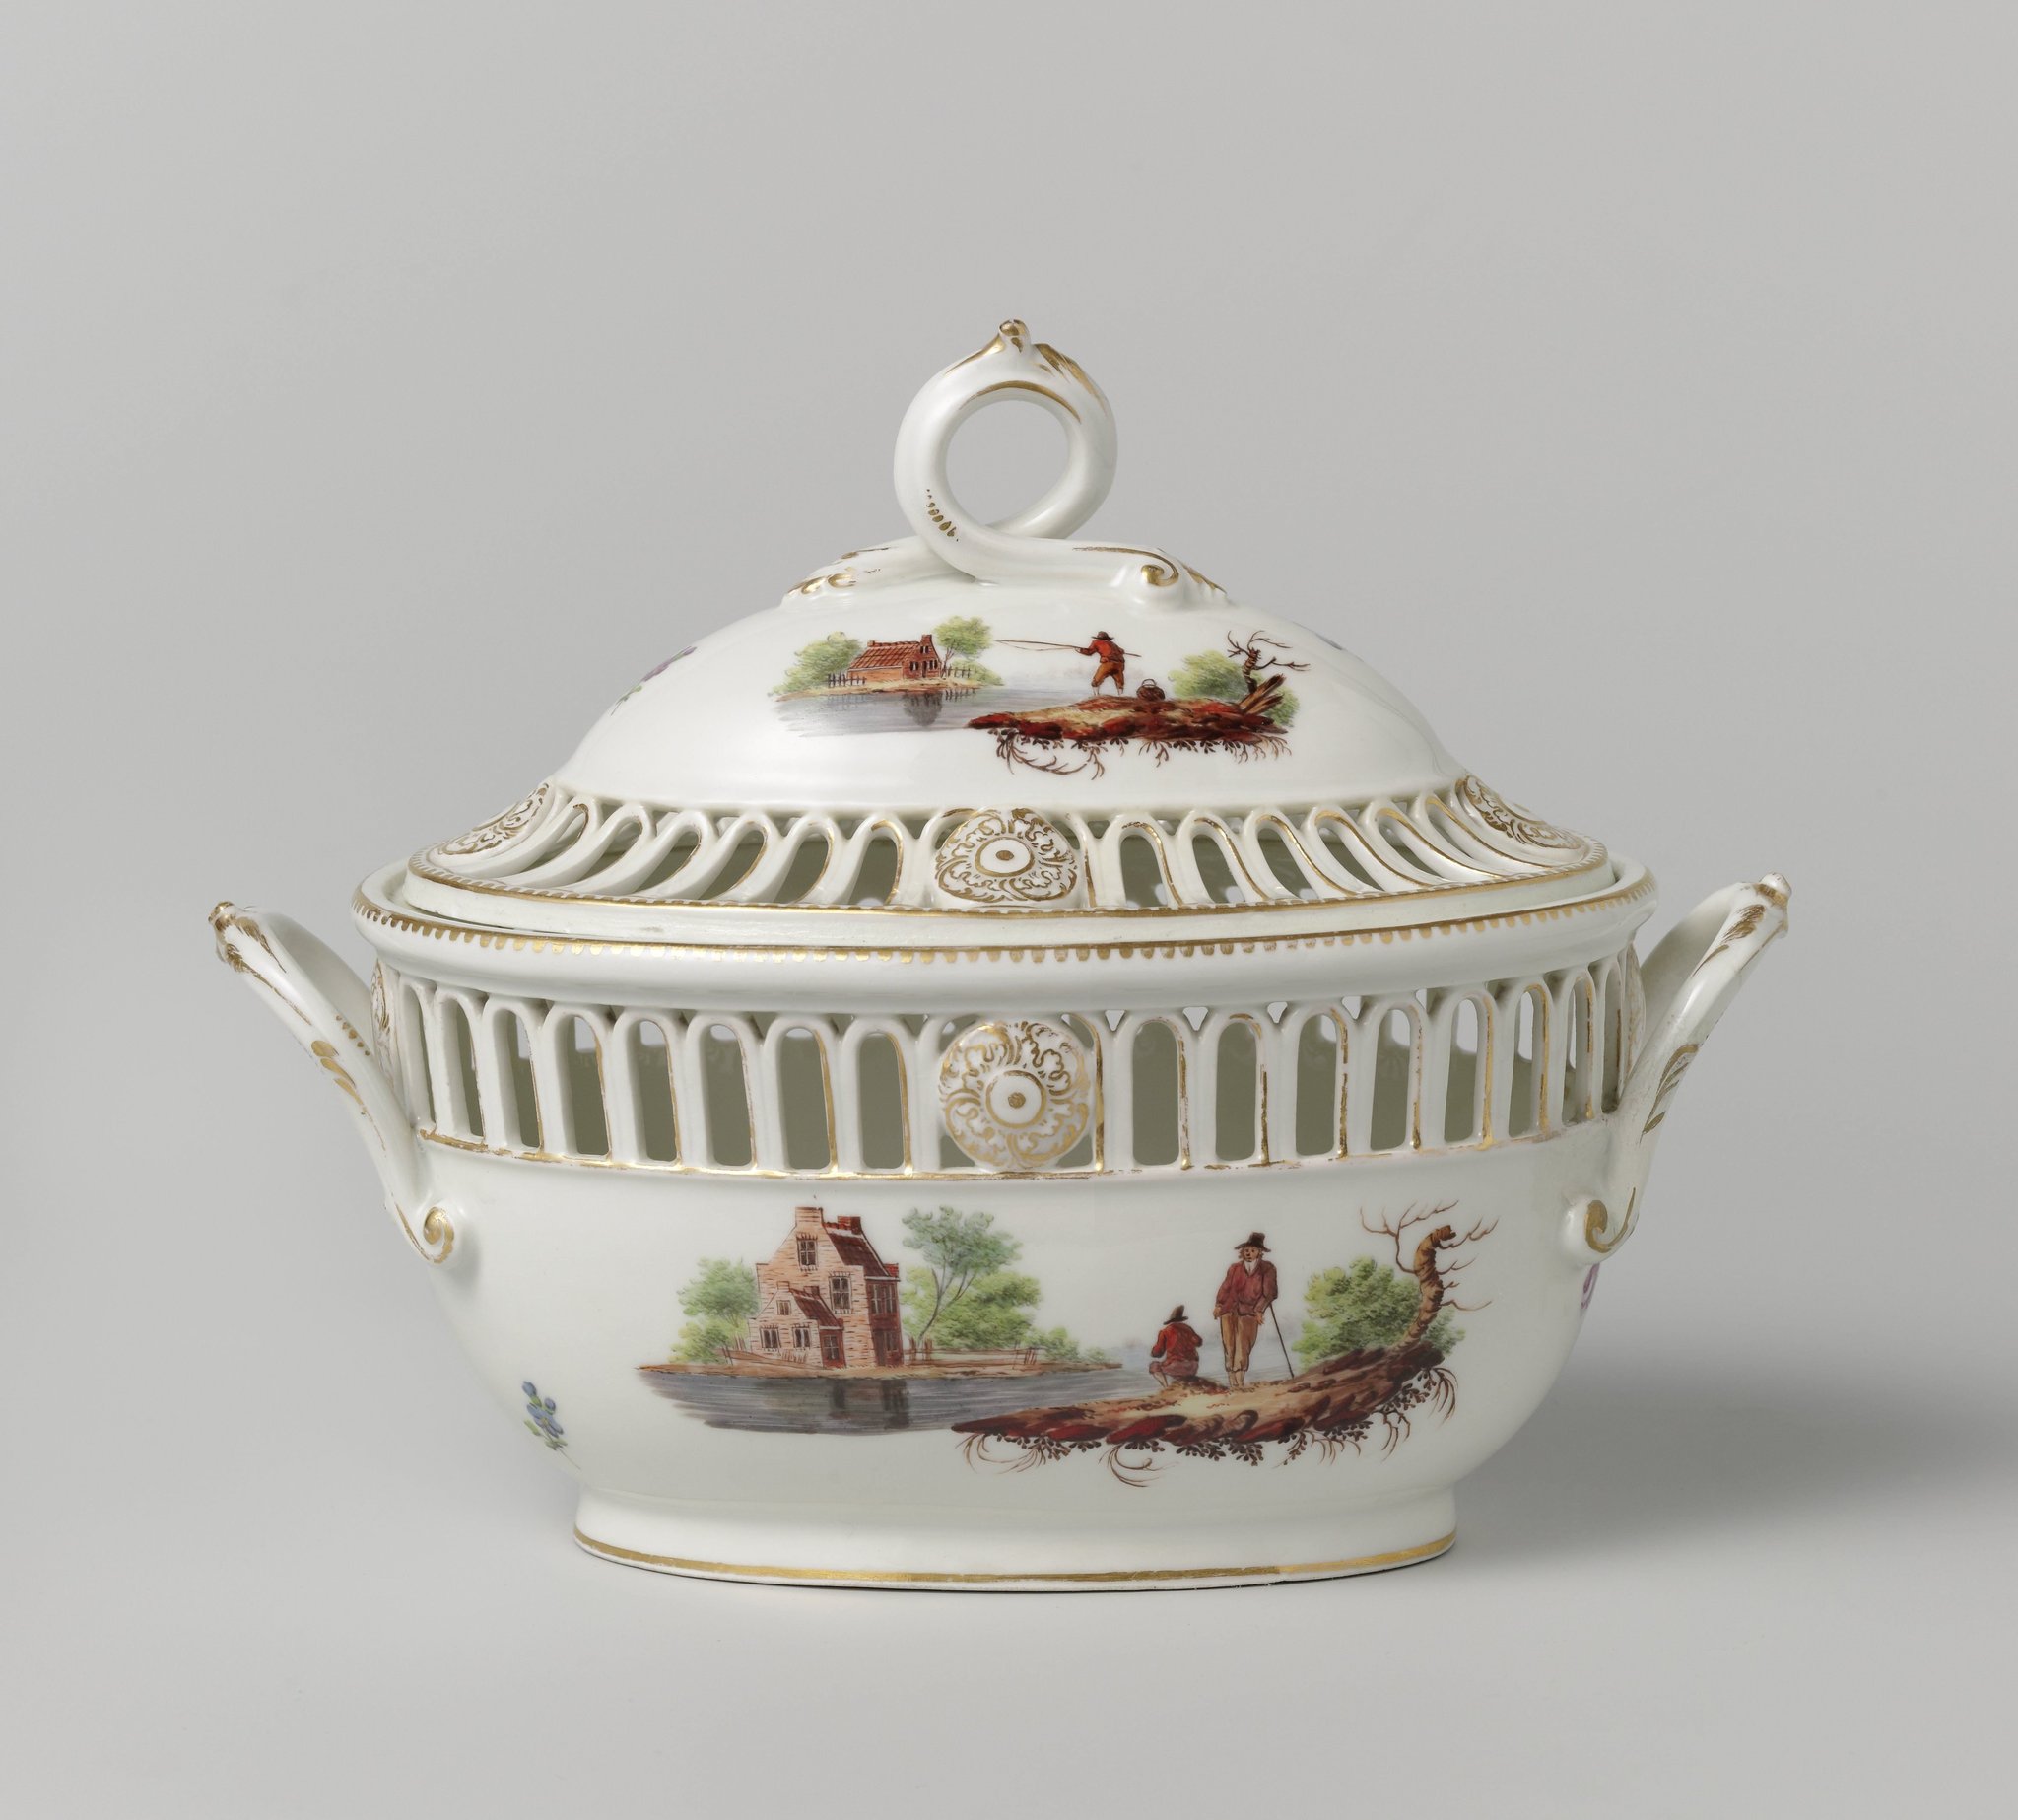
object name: tureen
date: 1782-1784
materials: porcelain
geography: loosdrecht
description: Manufactuur Oud-Loosdrecht Loosdrecht, c. 1782–1784 hard-paste porcelain